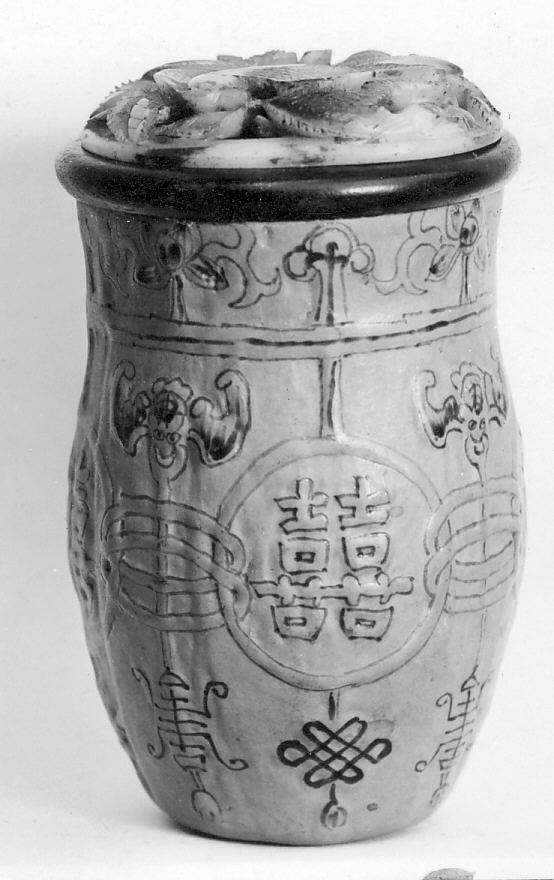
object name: cricket cage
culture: chinese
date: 1701-1900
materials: jade